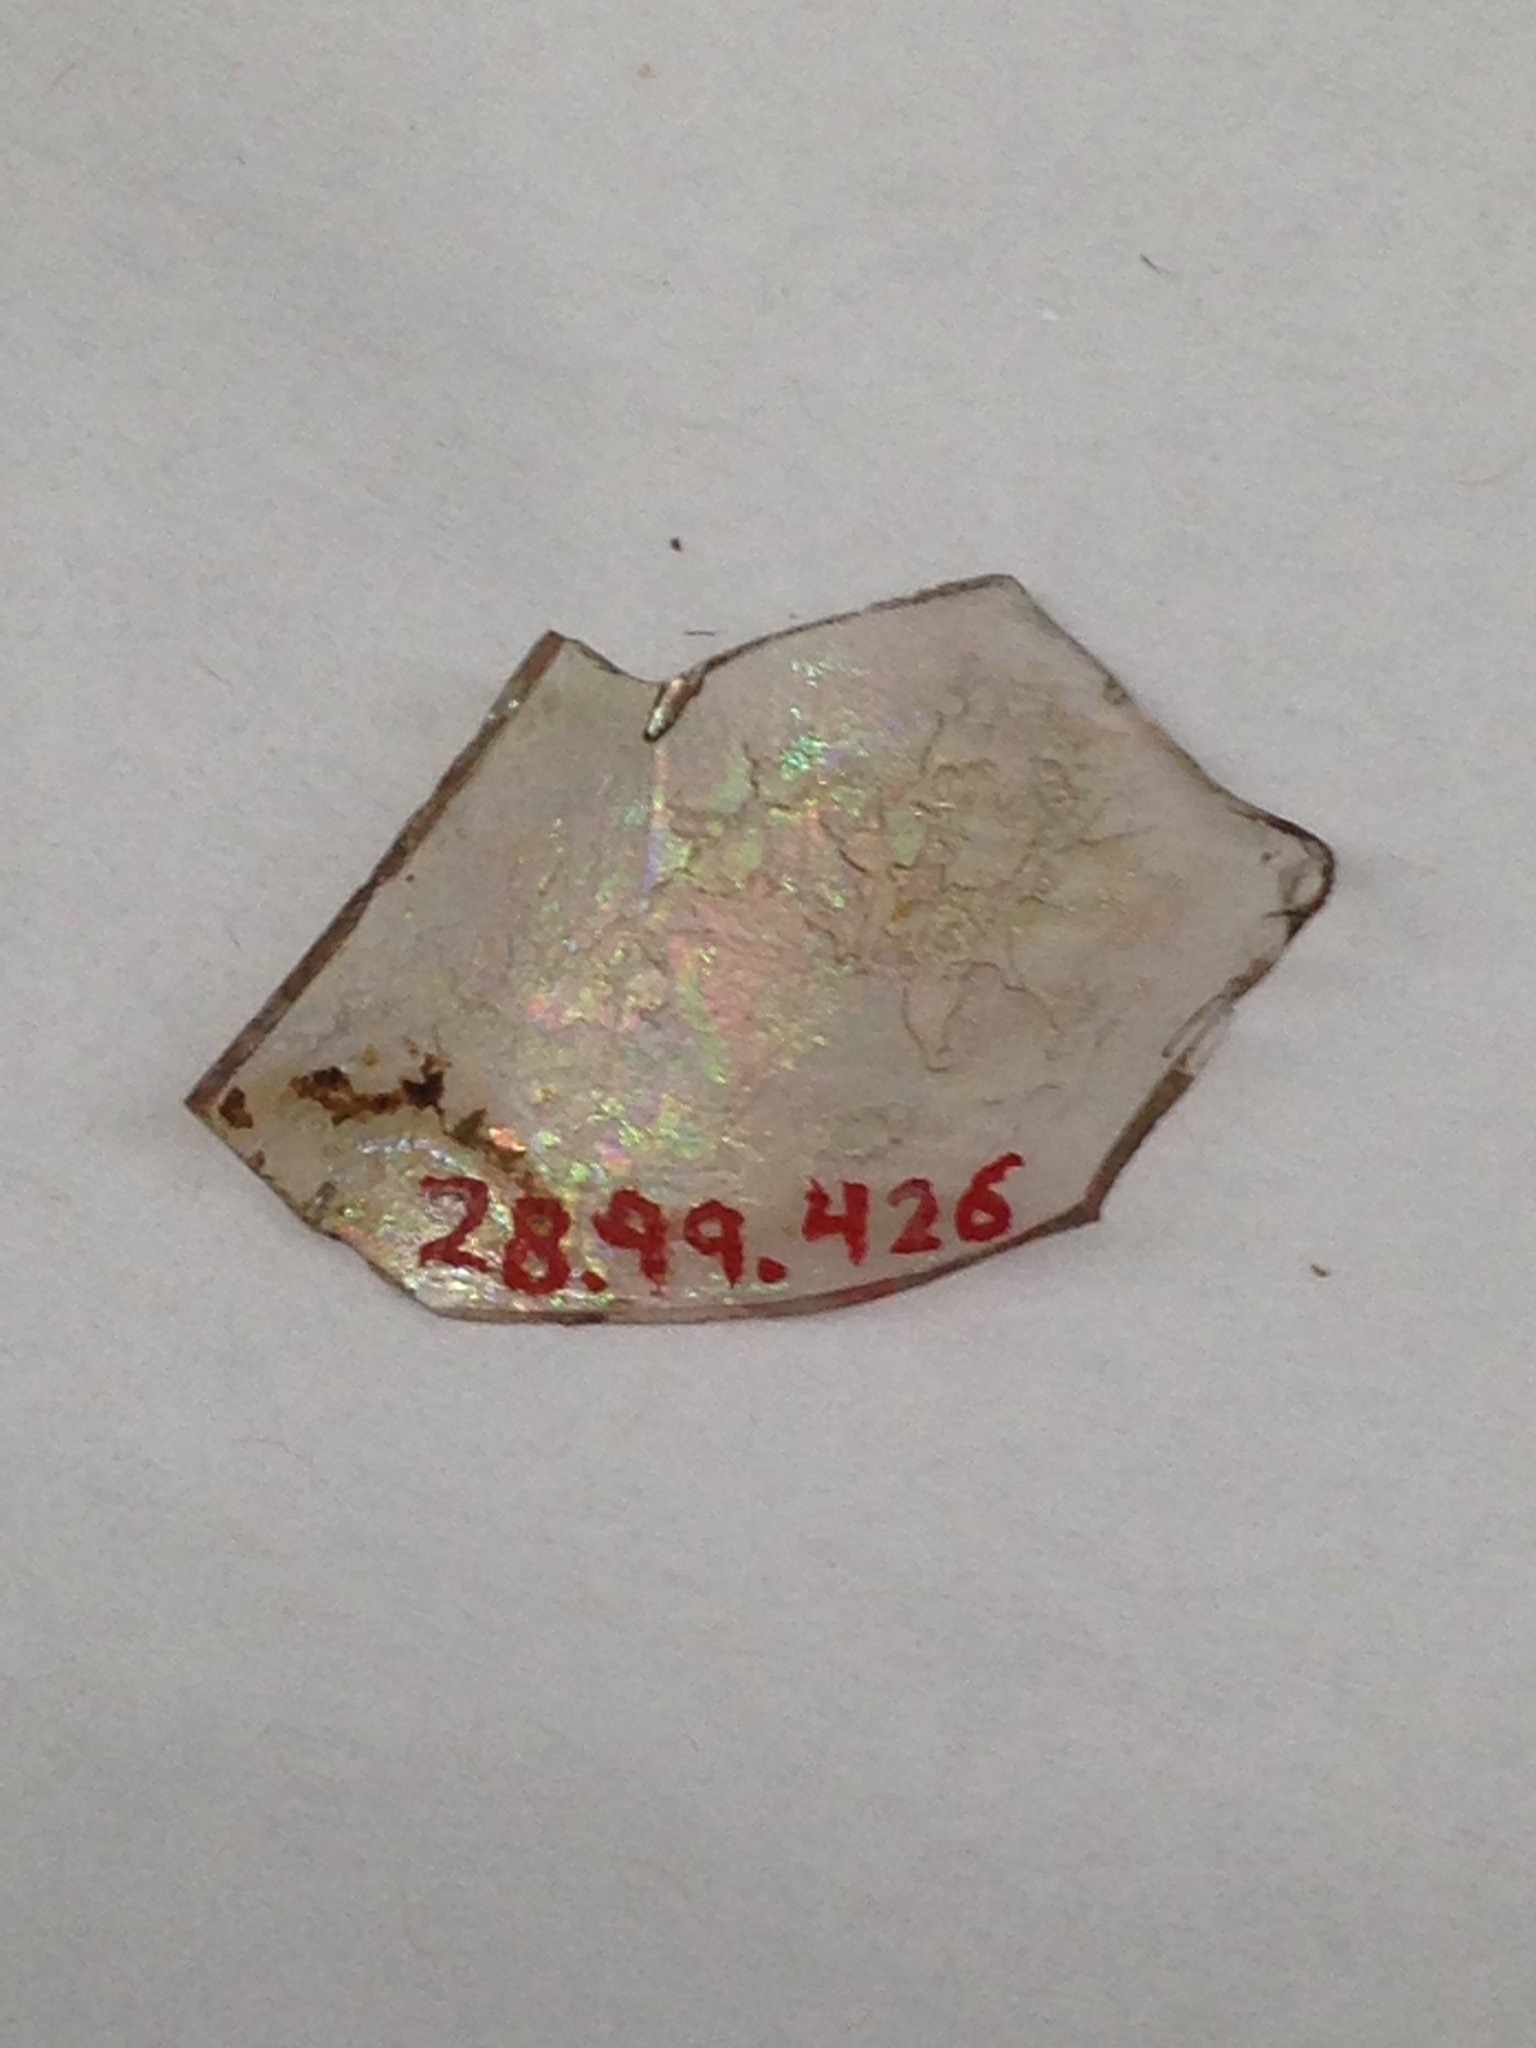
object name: fragment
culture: european or middle eastern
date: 1150-1250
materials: ceramic, glass